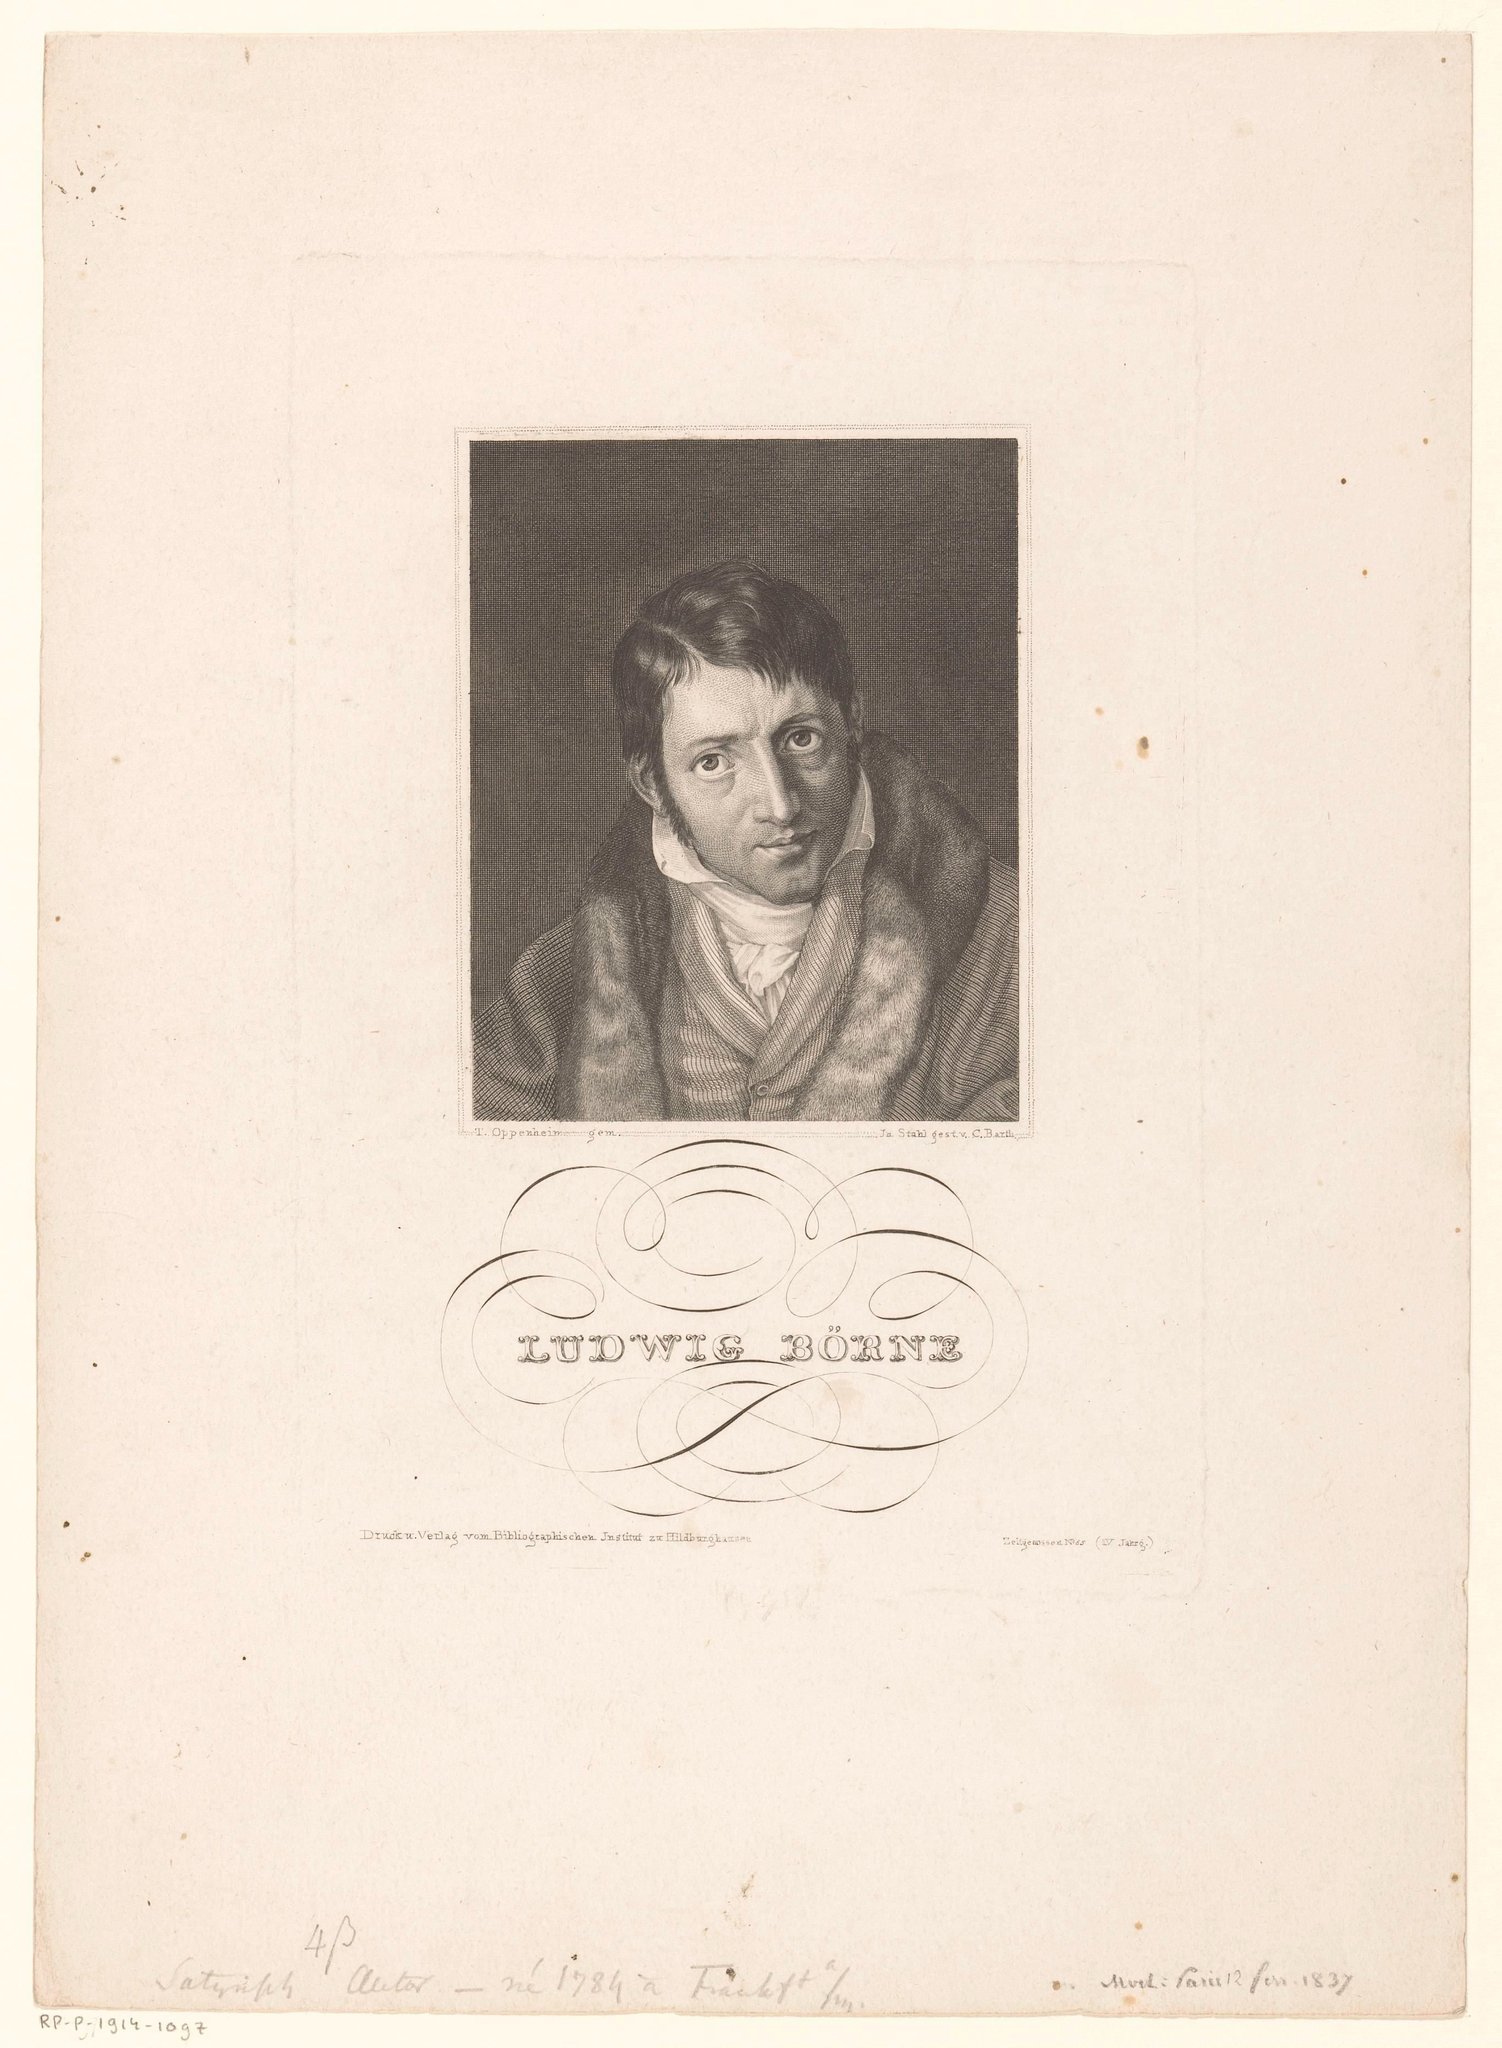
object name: print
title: Tijdgenoten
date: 1829-1840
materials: paper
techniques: engraving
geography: hildburghausen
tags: paris, historical persons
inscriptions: collector's mark: Lugt 2228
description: Afkomstig uit de portretserie 'Zeitgenossen', uitgegeven tussen 1829 en circa 1840.